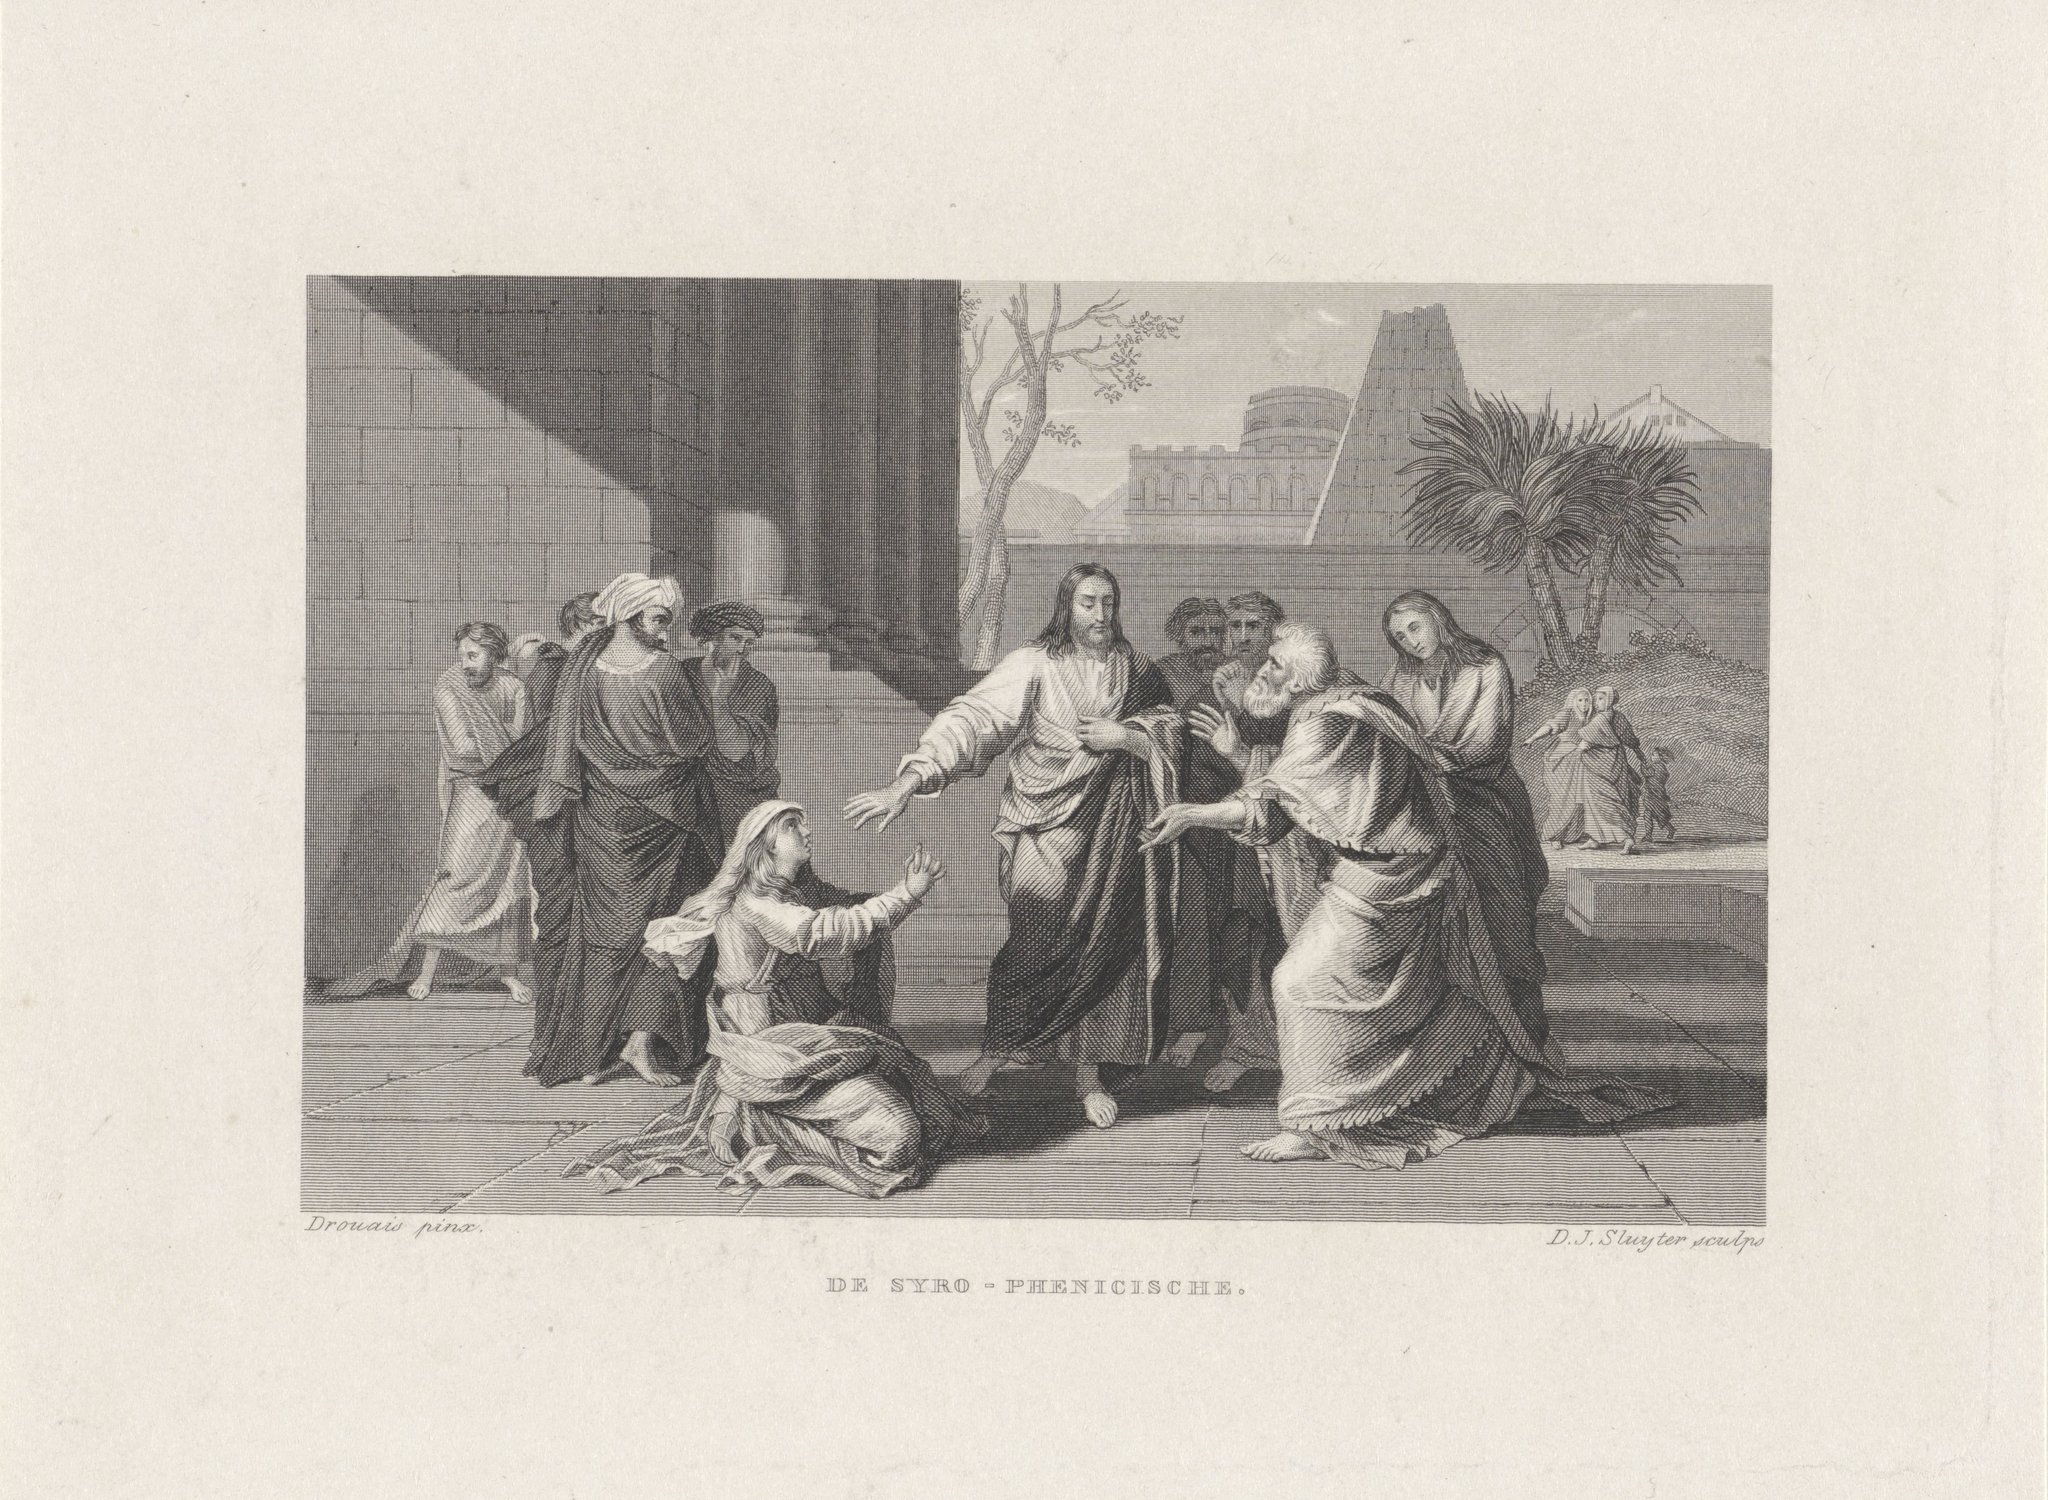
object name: print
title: De Syro-Phenicische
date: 1826-1886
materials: paper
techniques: etching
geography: amsterdam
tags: a canaanite woman kneels before christ, asking him to heal her daughter; the metaphor of the dogs and bread (matthew 15:21-28; mark 7:24-30)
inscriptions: collector's mark: Lugt 2228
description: Op een plein strekt Christus zijn hand uit naar een geknielde vrouw die hem smeekt haar dochter te genezen. Een man benadert hem vanaf de andere zijde. Om hen heen kijken groepjes mensen toe. Illustratie van Marcus 7:26.